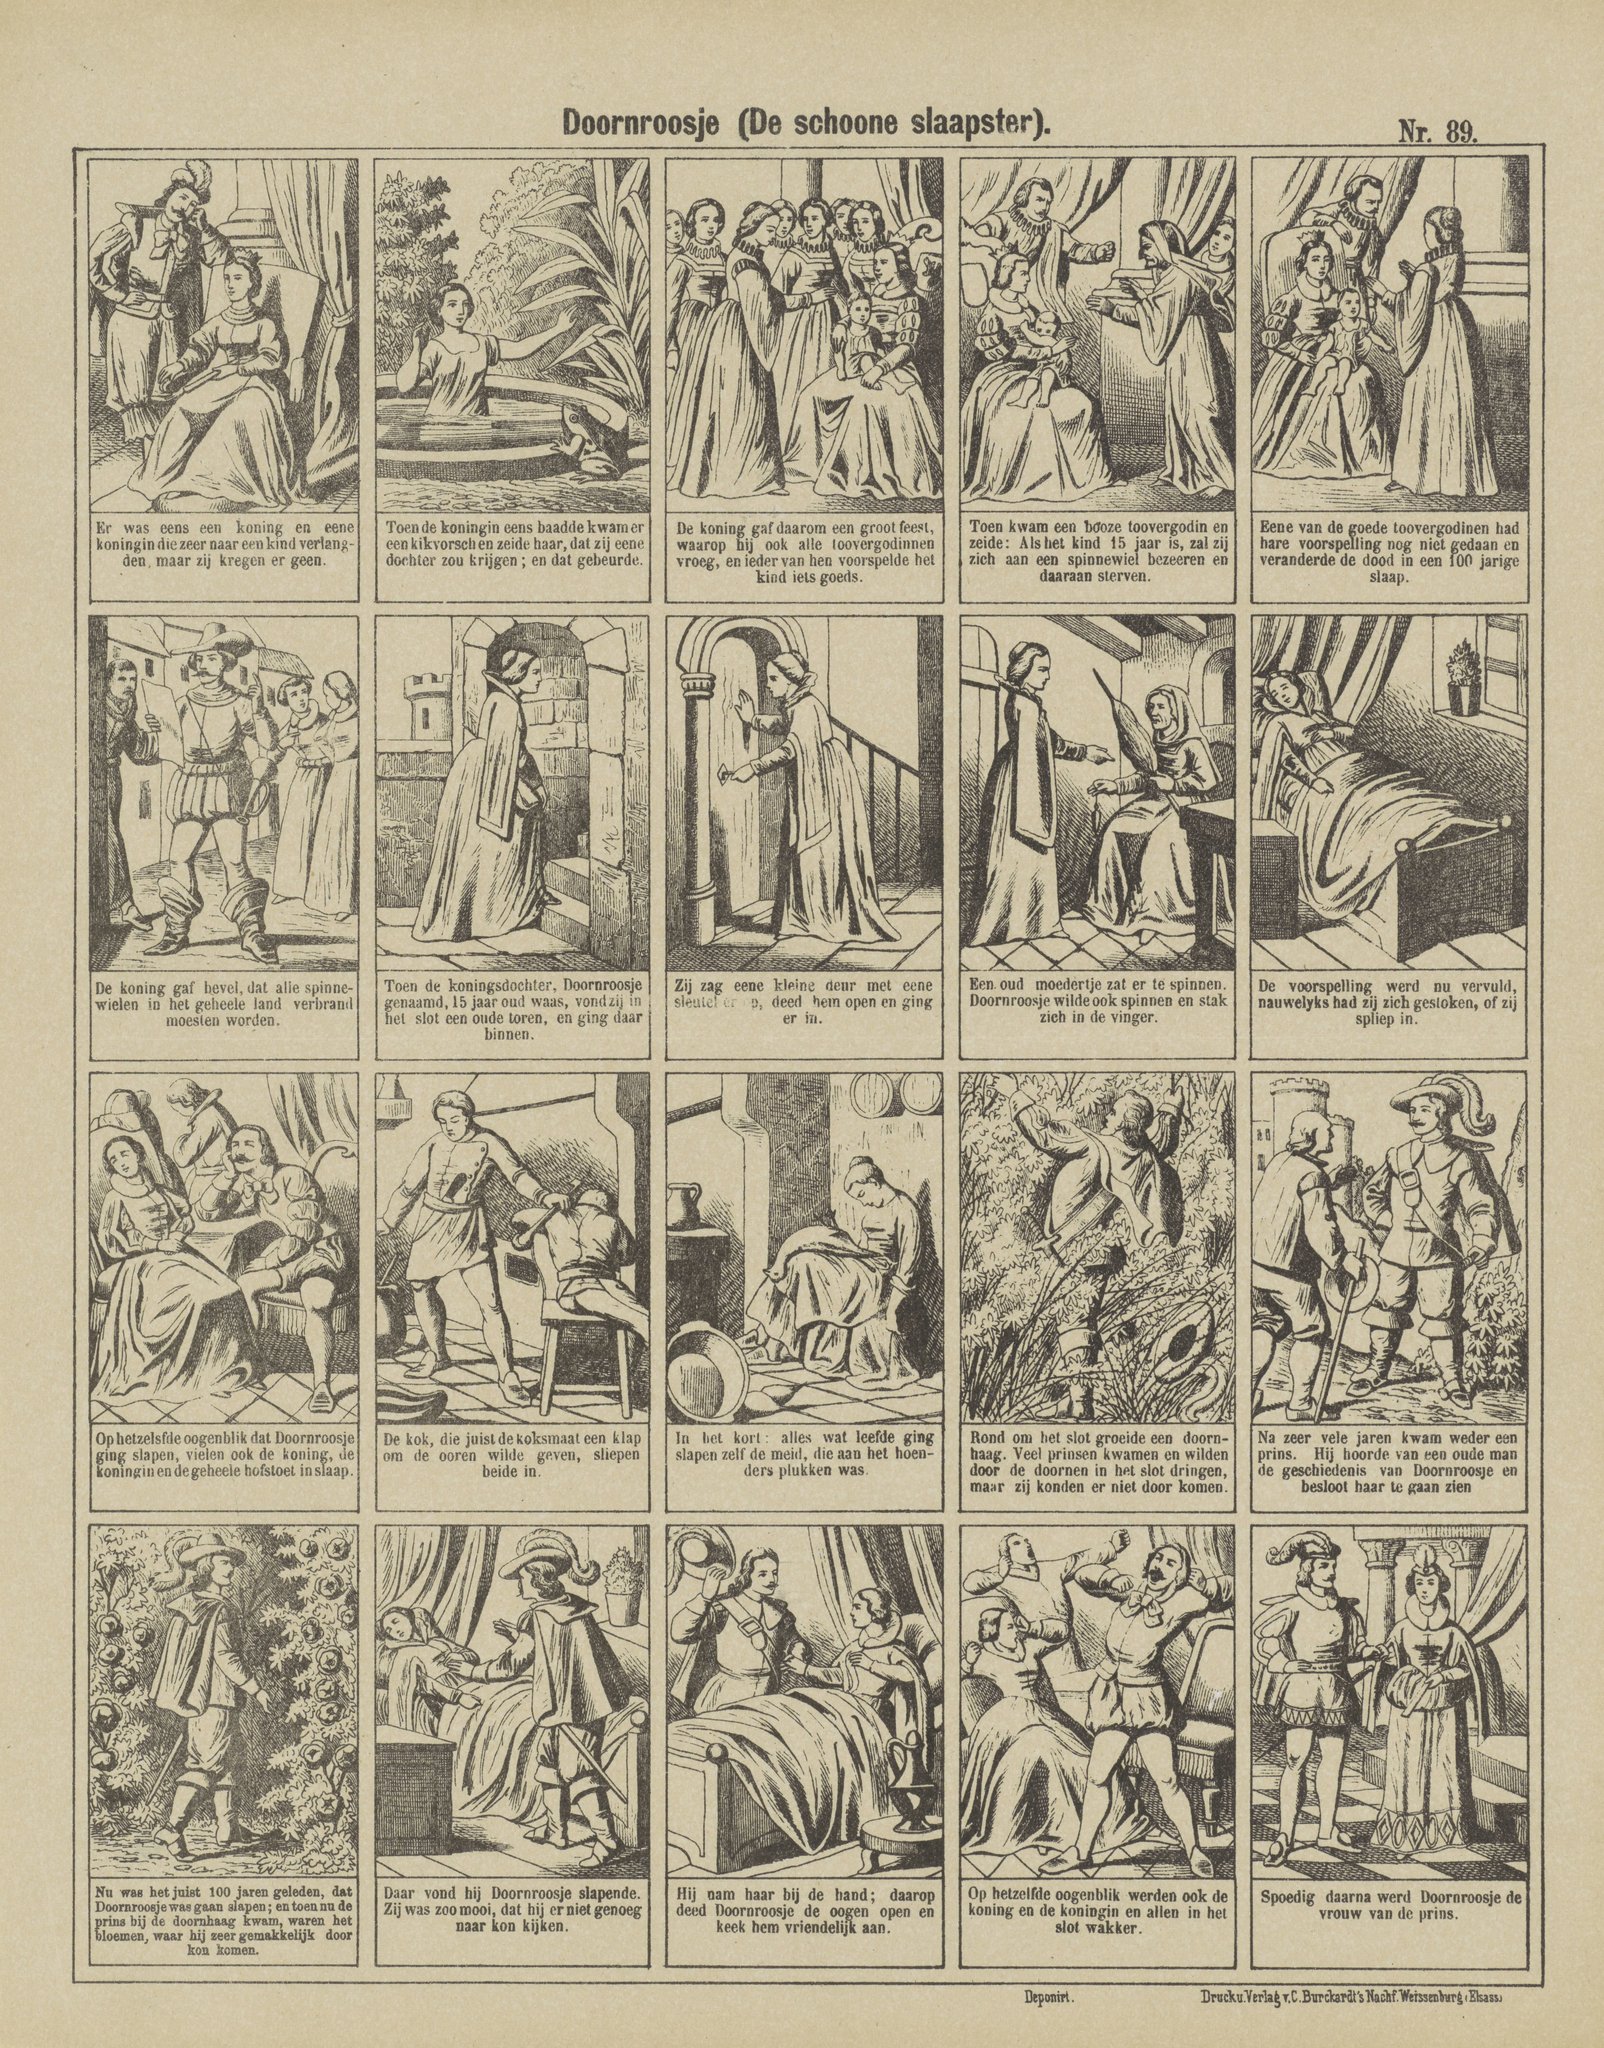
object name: print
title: Doornroosje (de schoone slaapster)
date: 1889-1906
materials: paper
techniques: letterpress printing, lithograph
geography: wissembourg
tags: tales and fairy tales: sleeping beauty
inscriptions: collector's mark: Lugt 2760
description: Blad met 20 voorstellingen uit het sprookje van Doornroosje. Onder elke afbeelding een onderschrift. Genummerd rechtsboven: No. 89.